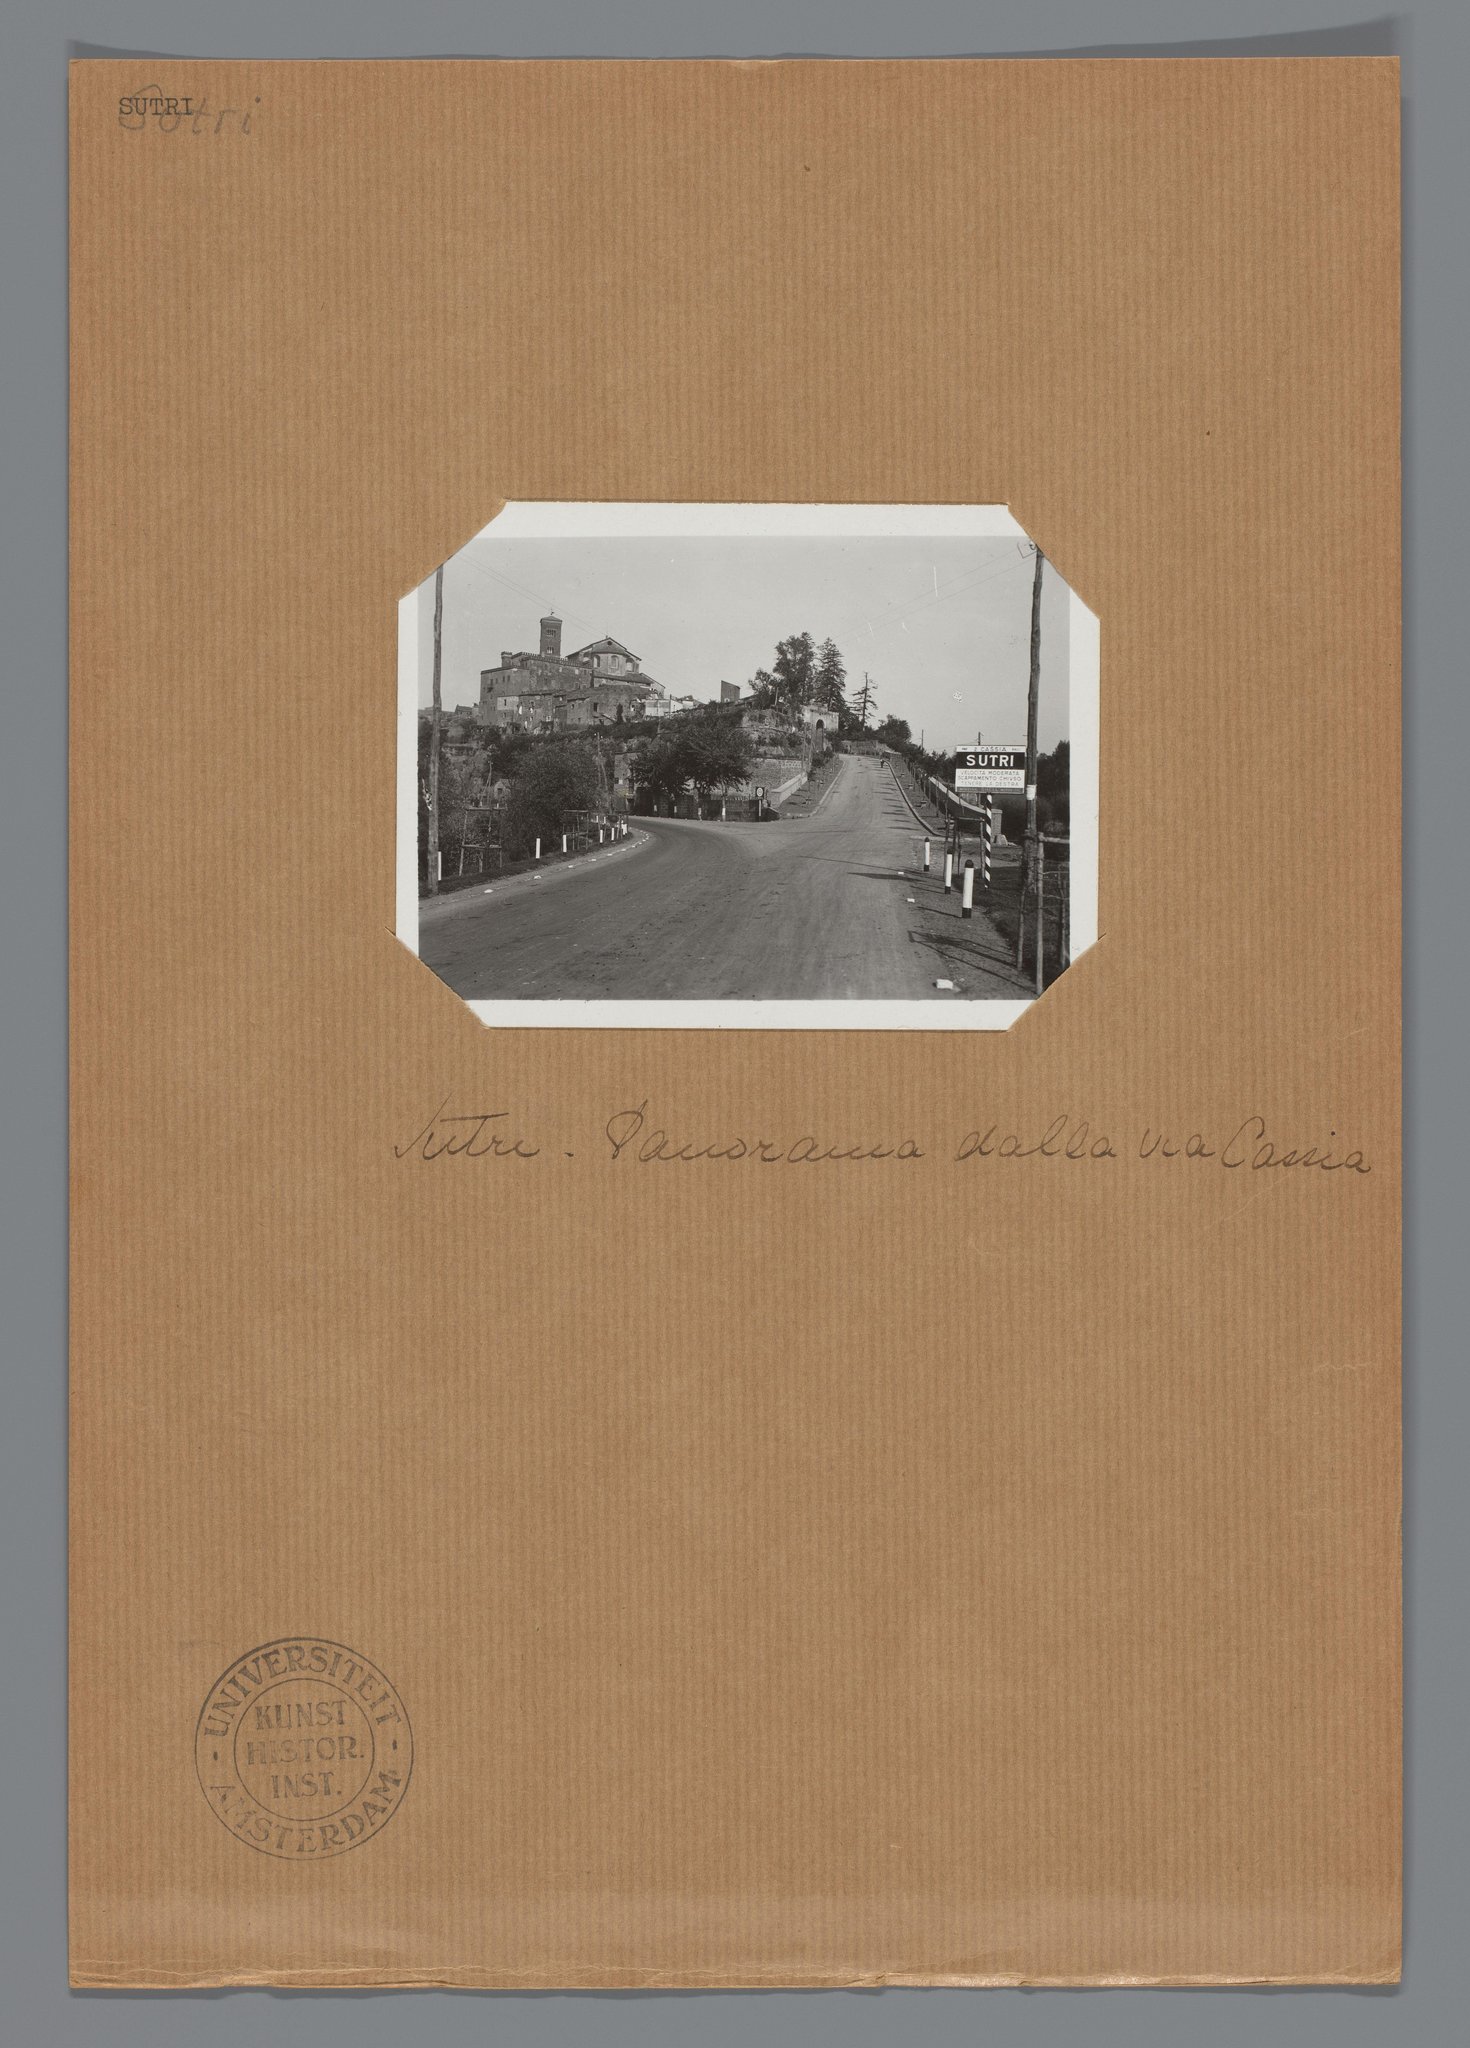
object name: photograph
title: Italië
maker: Anonymous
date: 1880-1910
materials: photographic support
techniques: albumen print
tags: italy